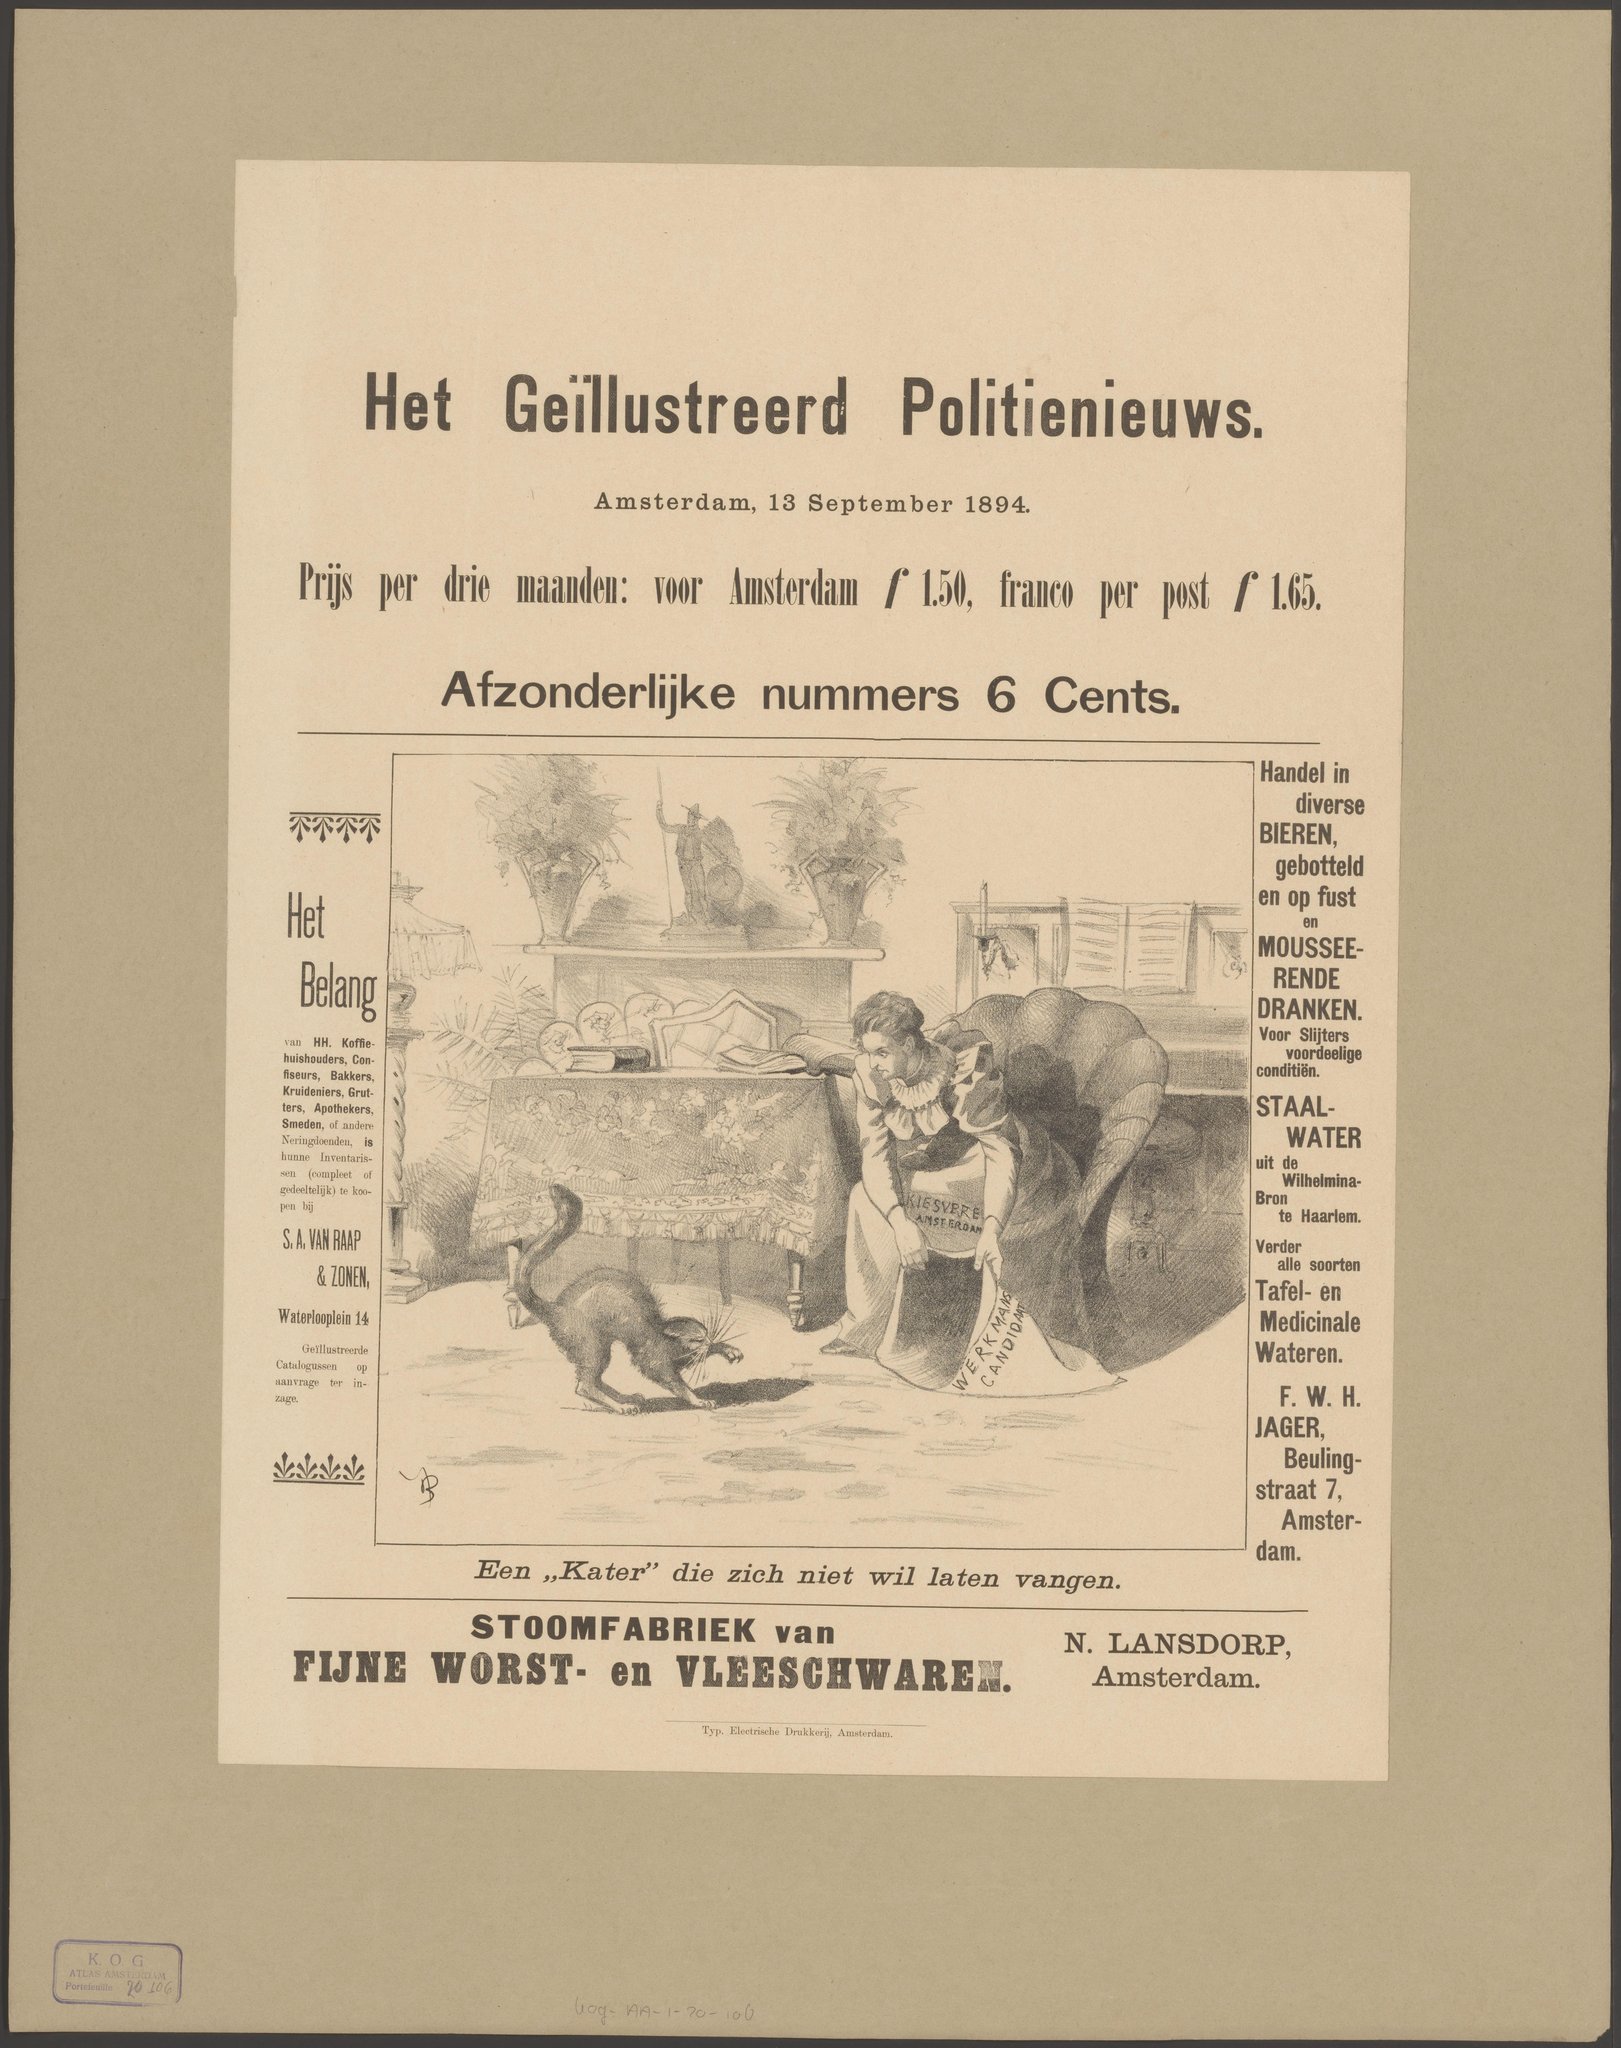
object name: cartoon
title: Een "Kater" die zich niet wil laten vangen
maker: johan braakensiek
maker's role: draughtsman, print maker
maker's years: 1858-1940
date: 1894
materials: paper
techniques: letterpress printing, lithograph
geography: amsterdam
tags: cat, bag, political caricatures and satires, amsterdam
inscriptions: collector's mark: Lugt 1641b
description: Gepubliceerd als bijvoegsel van 'Het Geïllustreerd Politienieuws', 13 september 1894.